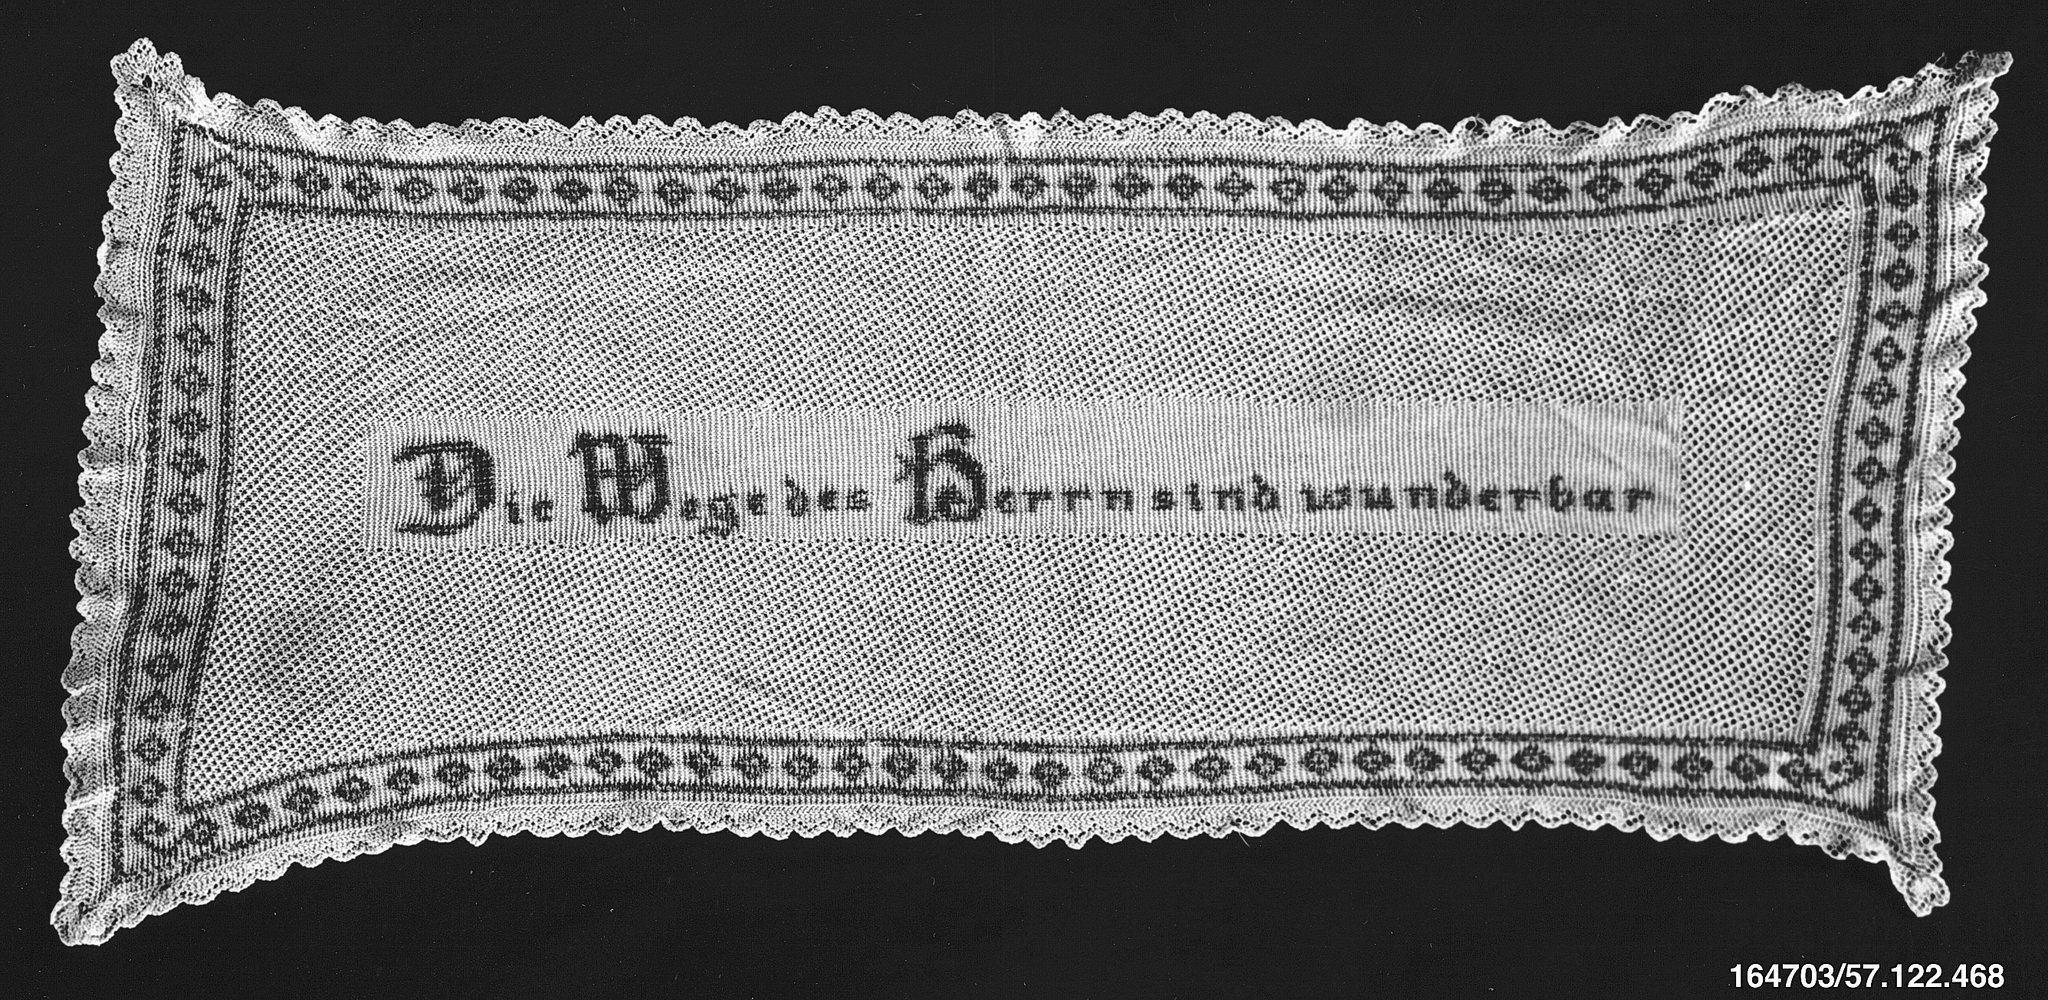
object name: sampler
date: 1801-1900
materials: silk